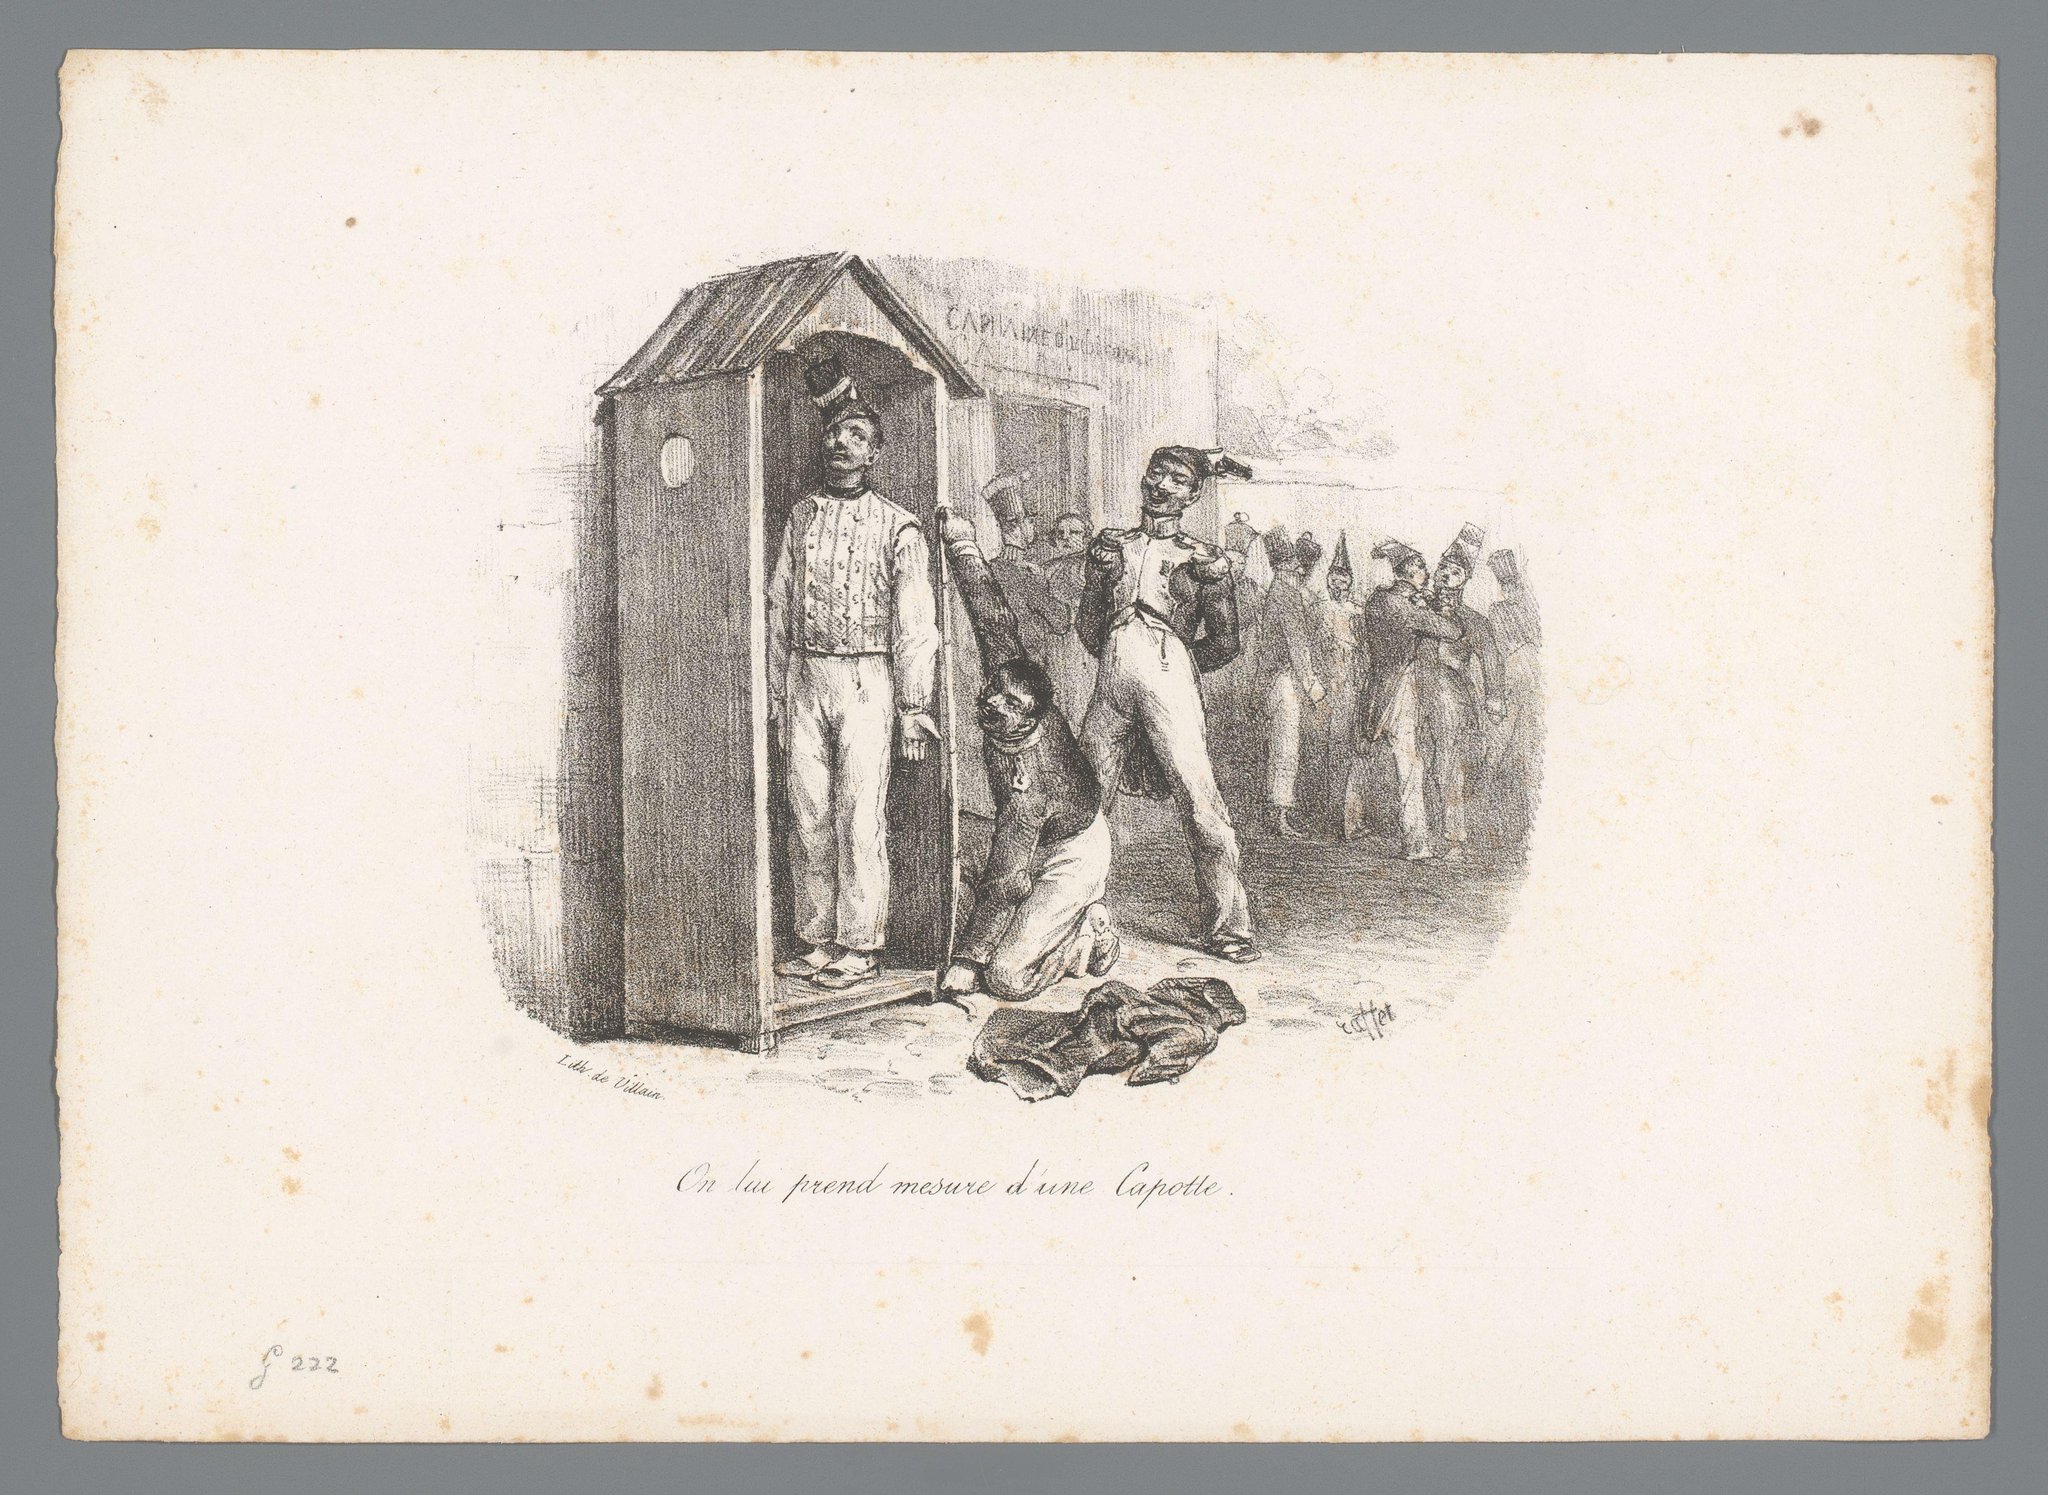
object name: print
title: Histoire de Jean-Jean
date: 1825-1829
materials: paper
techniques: lithograph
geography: paris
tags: tailor, dressmaker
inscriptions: collector's mark: Lugt 964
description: Serie bestaat uit titelprent en zestien prenten. Derde prent in de serie van zeventien prenten.